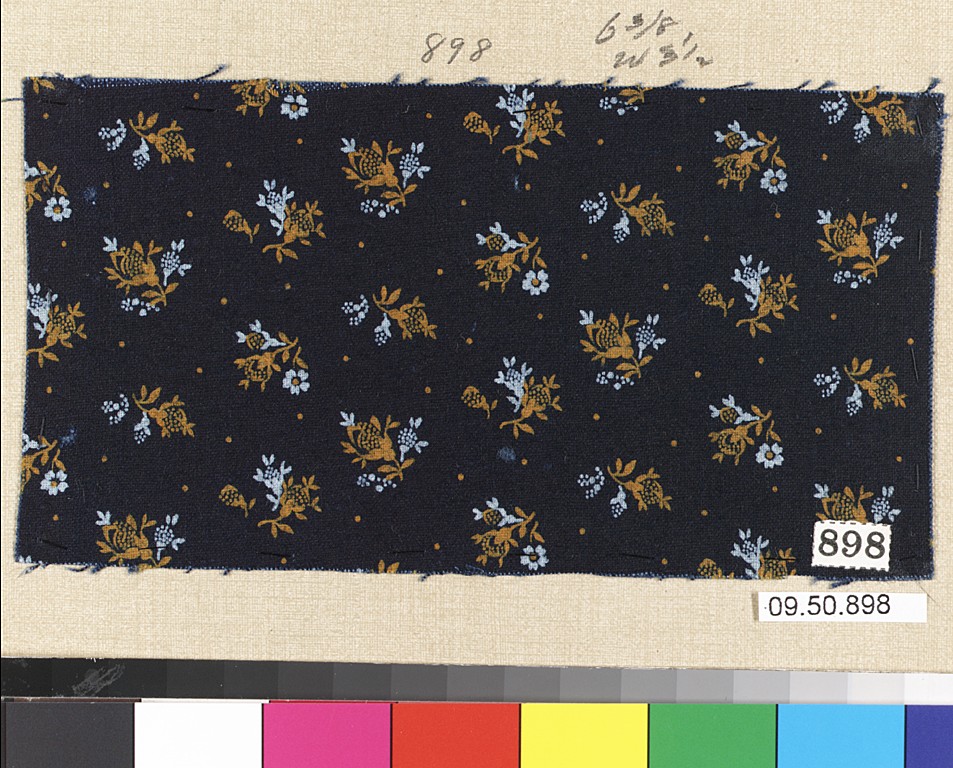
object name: piece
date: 1801-1900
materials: cotton